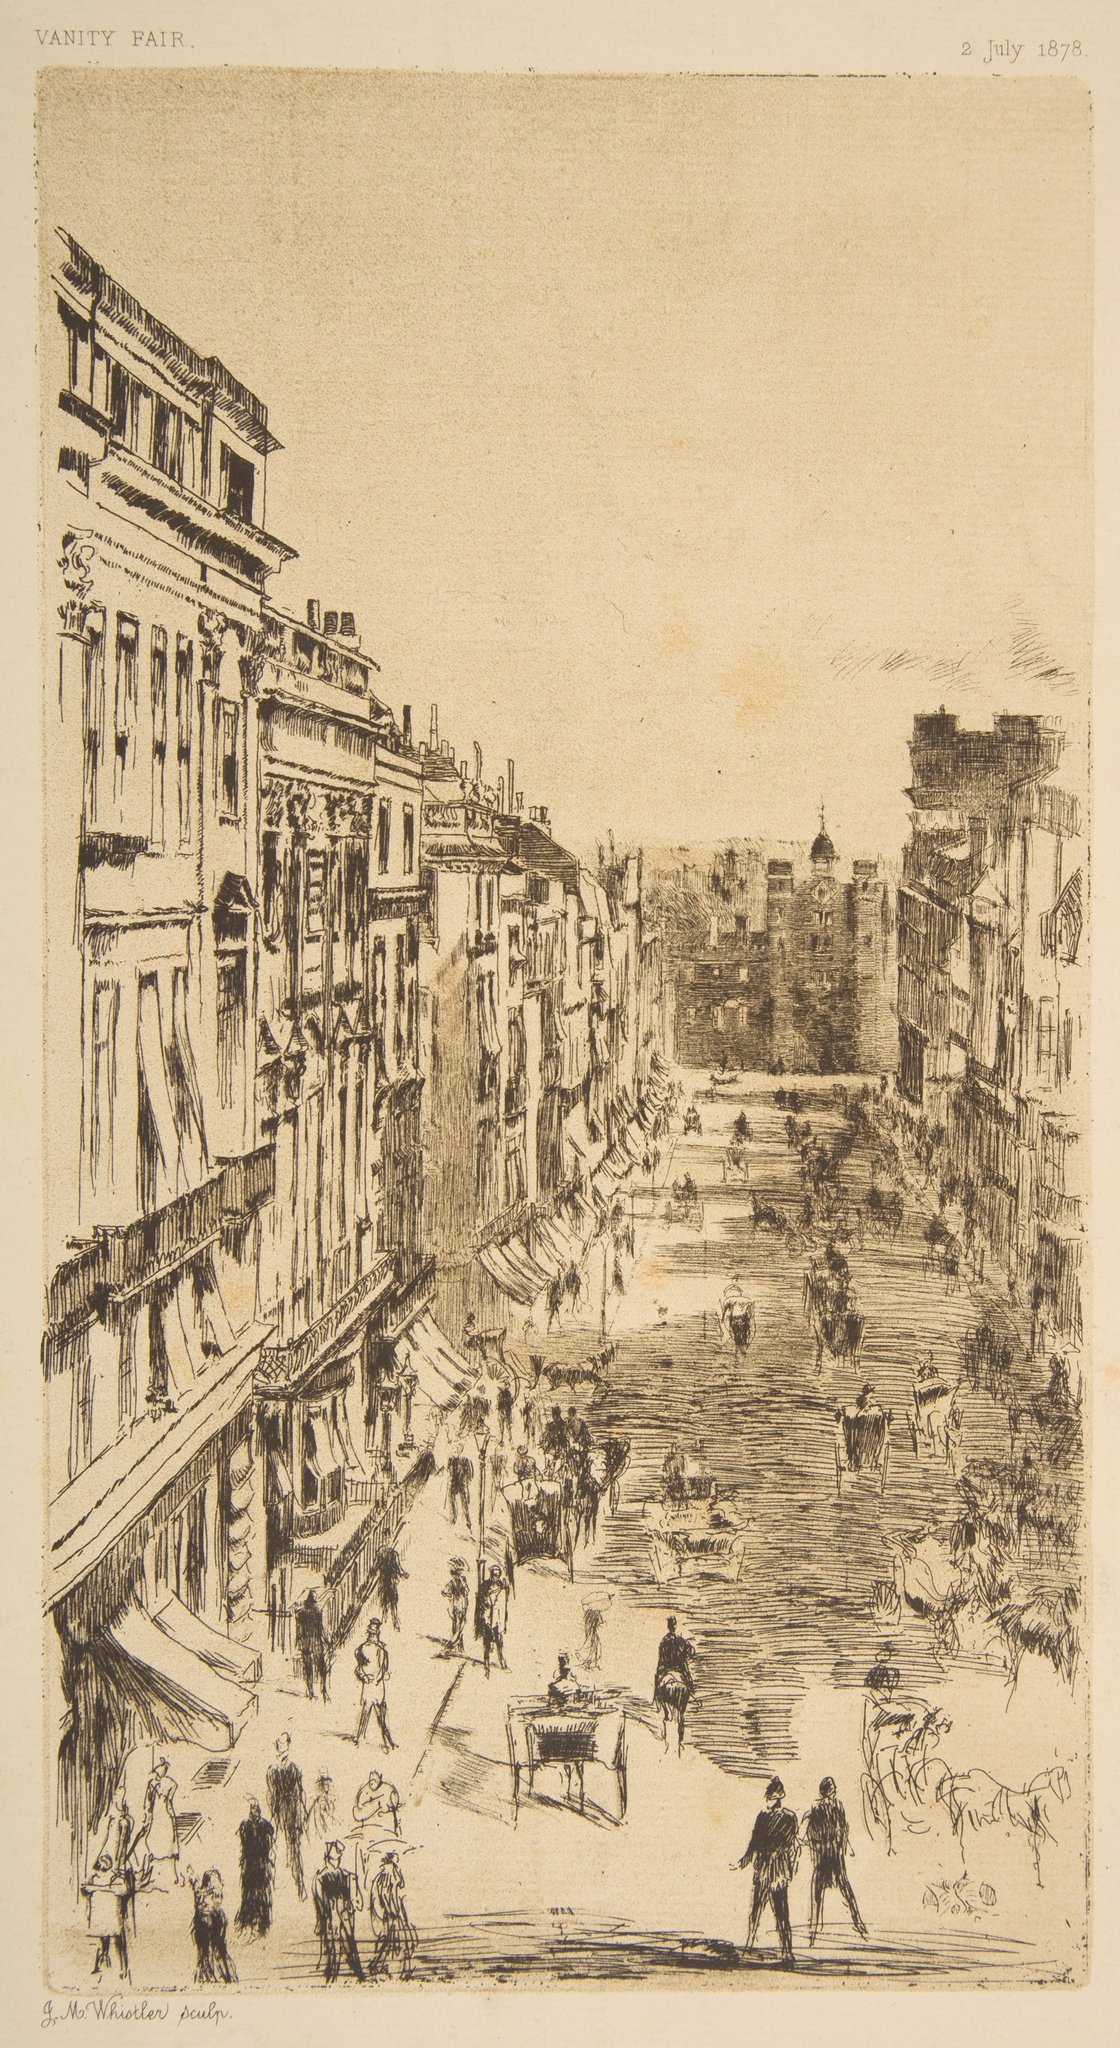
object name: print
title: St. James's Street--June 1878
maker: james mcneill whistler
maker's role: artist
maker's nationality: american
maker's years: 1834-1903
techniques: etching, lithograph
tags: human figures,buildings,streets